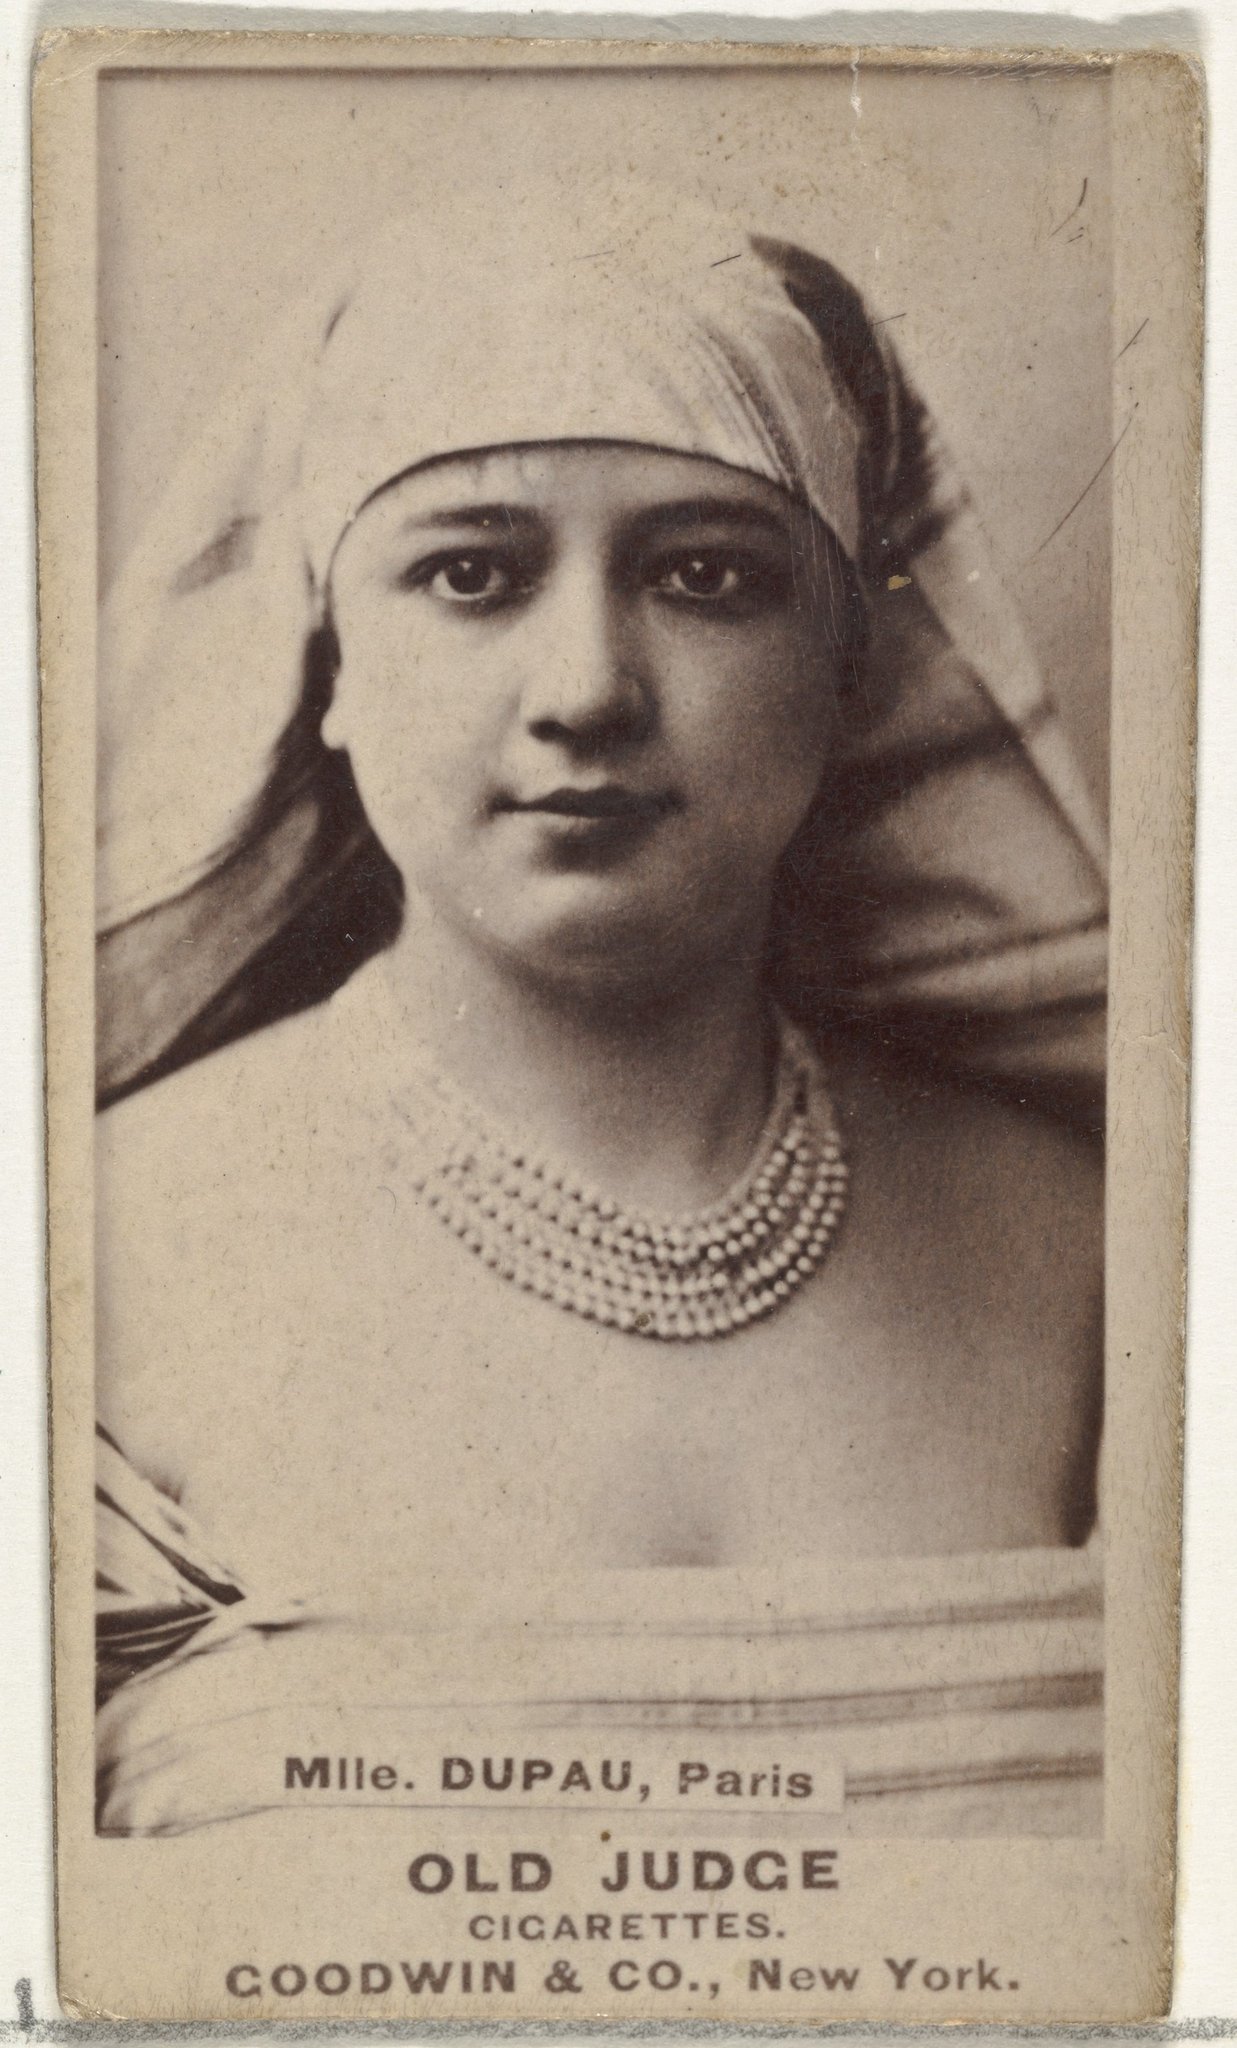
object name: photograph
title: Mlle. Dupau, Paris, from the Actors and Actresses series (N171) for Old Judge Cigarettes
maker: goodwin & company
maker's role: publisher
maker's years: 1850-1950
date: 1886-1890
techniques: albumen silver print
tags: portraits,women,actresses